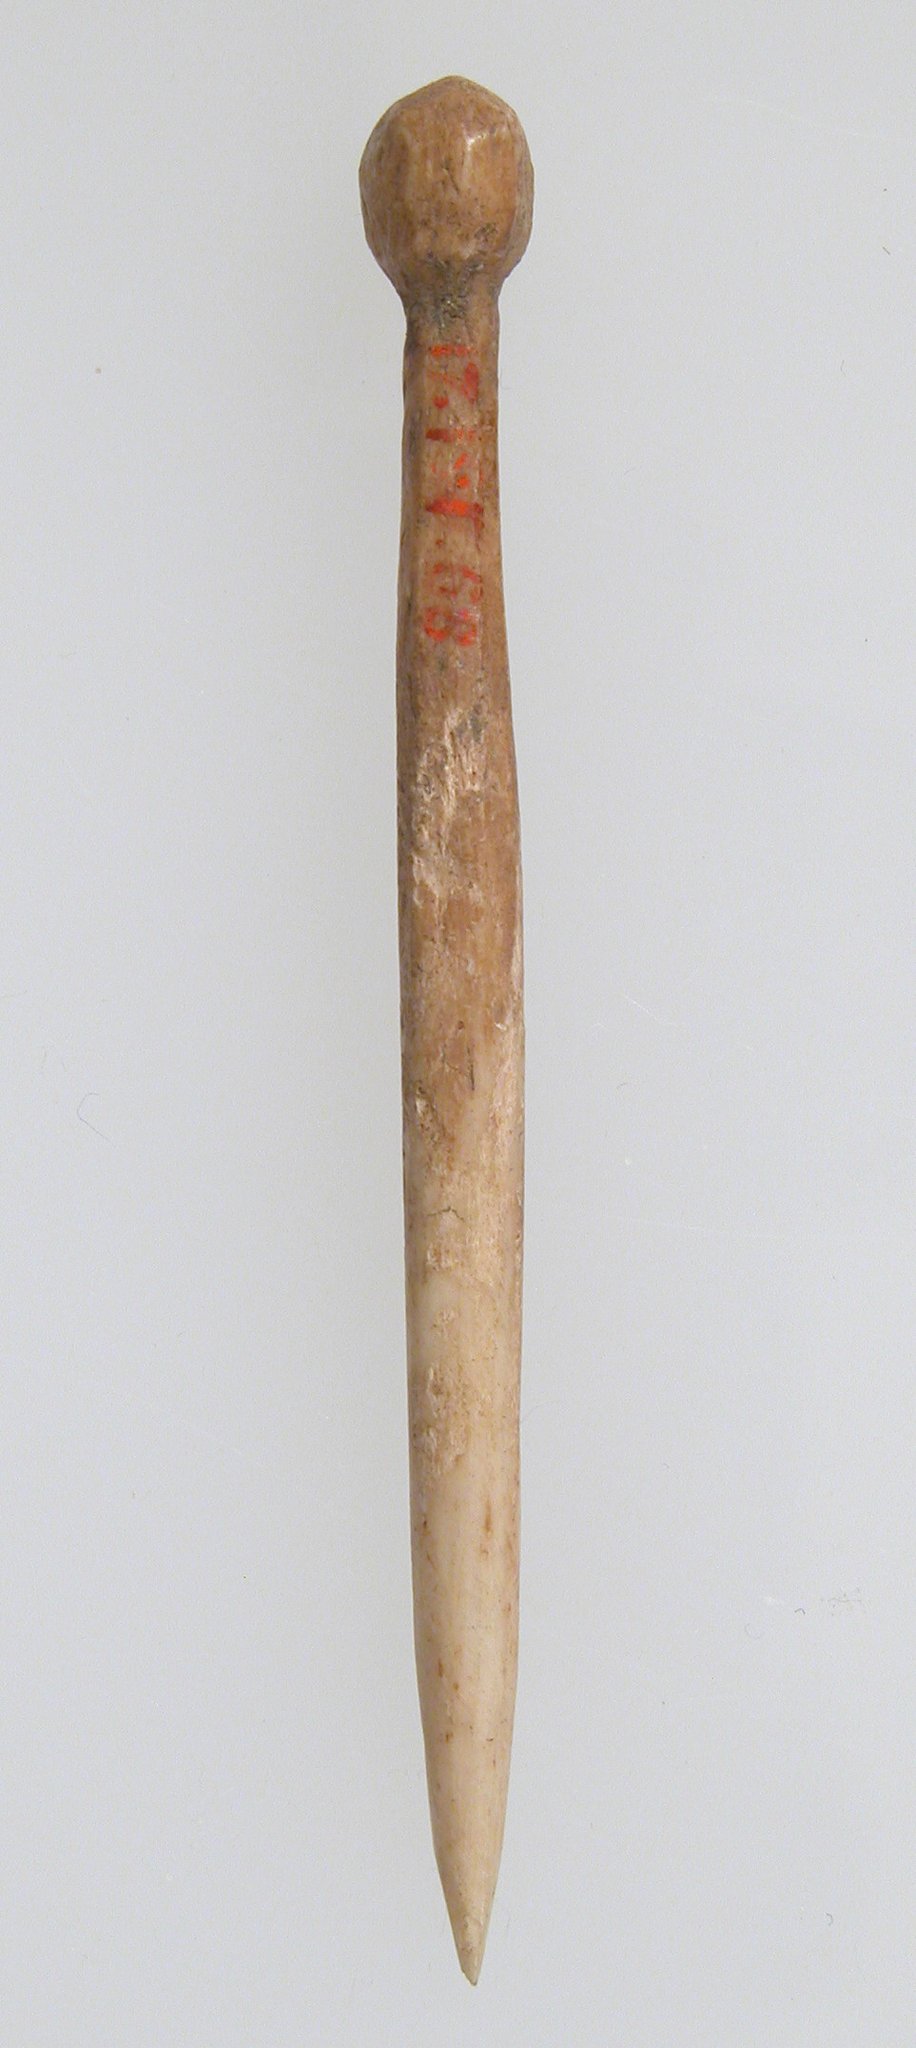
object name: pin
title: Short Pin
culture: roman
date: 1-400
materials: bone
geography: northern france